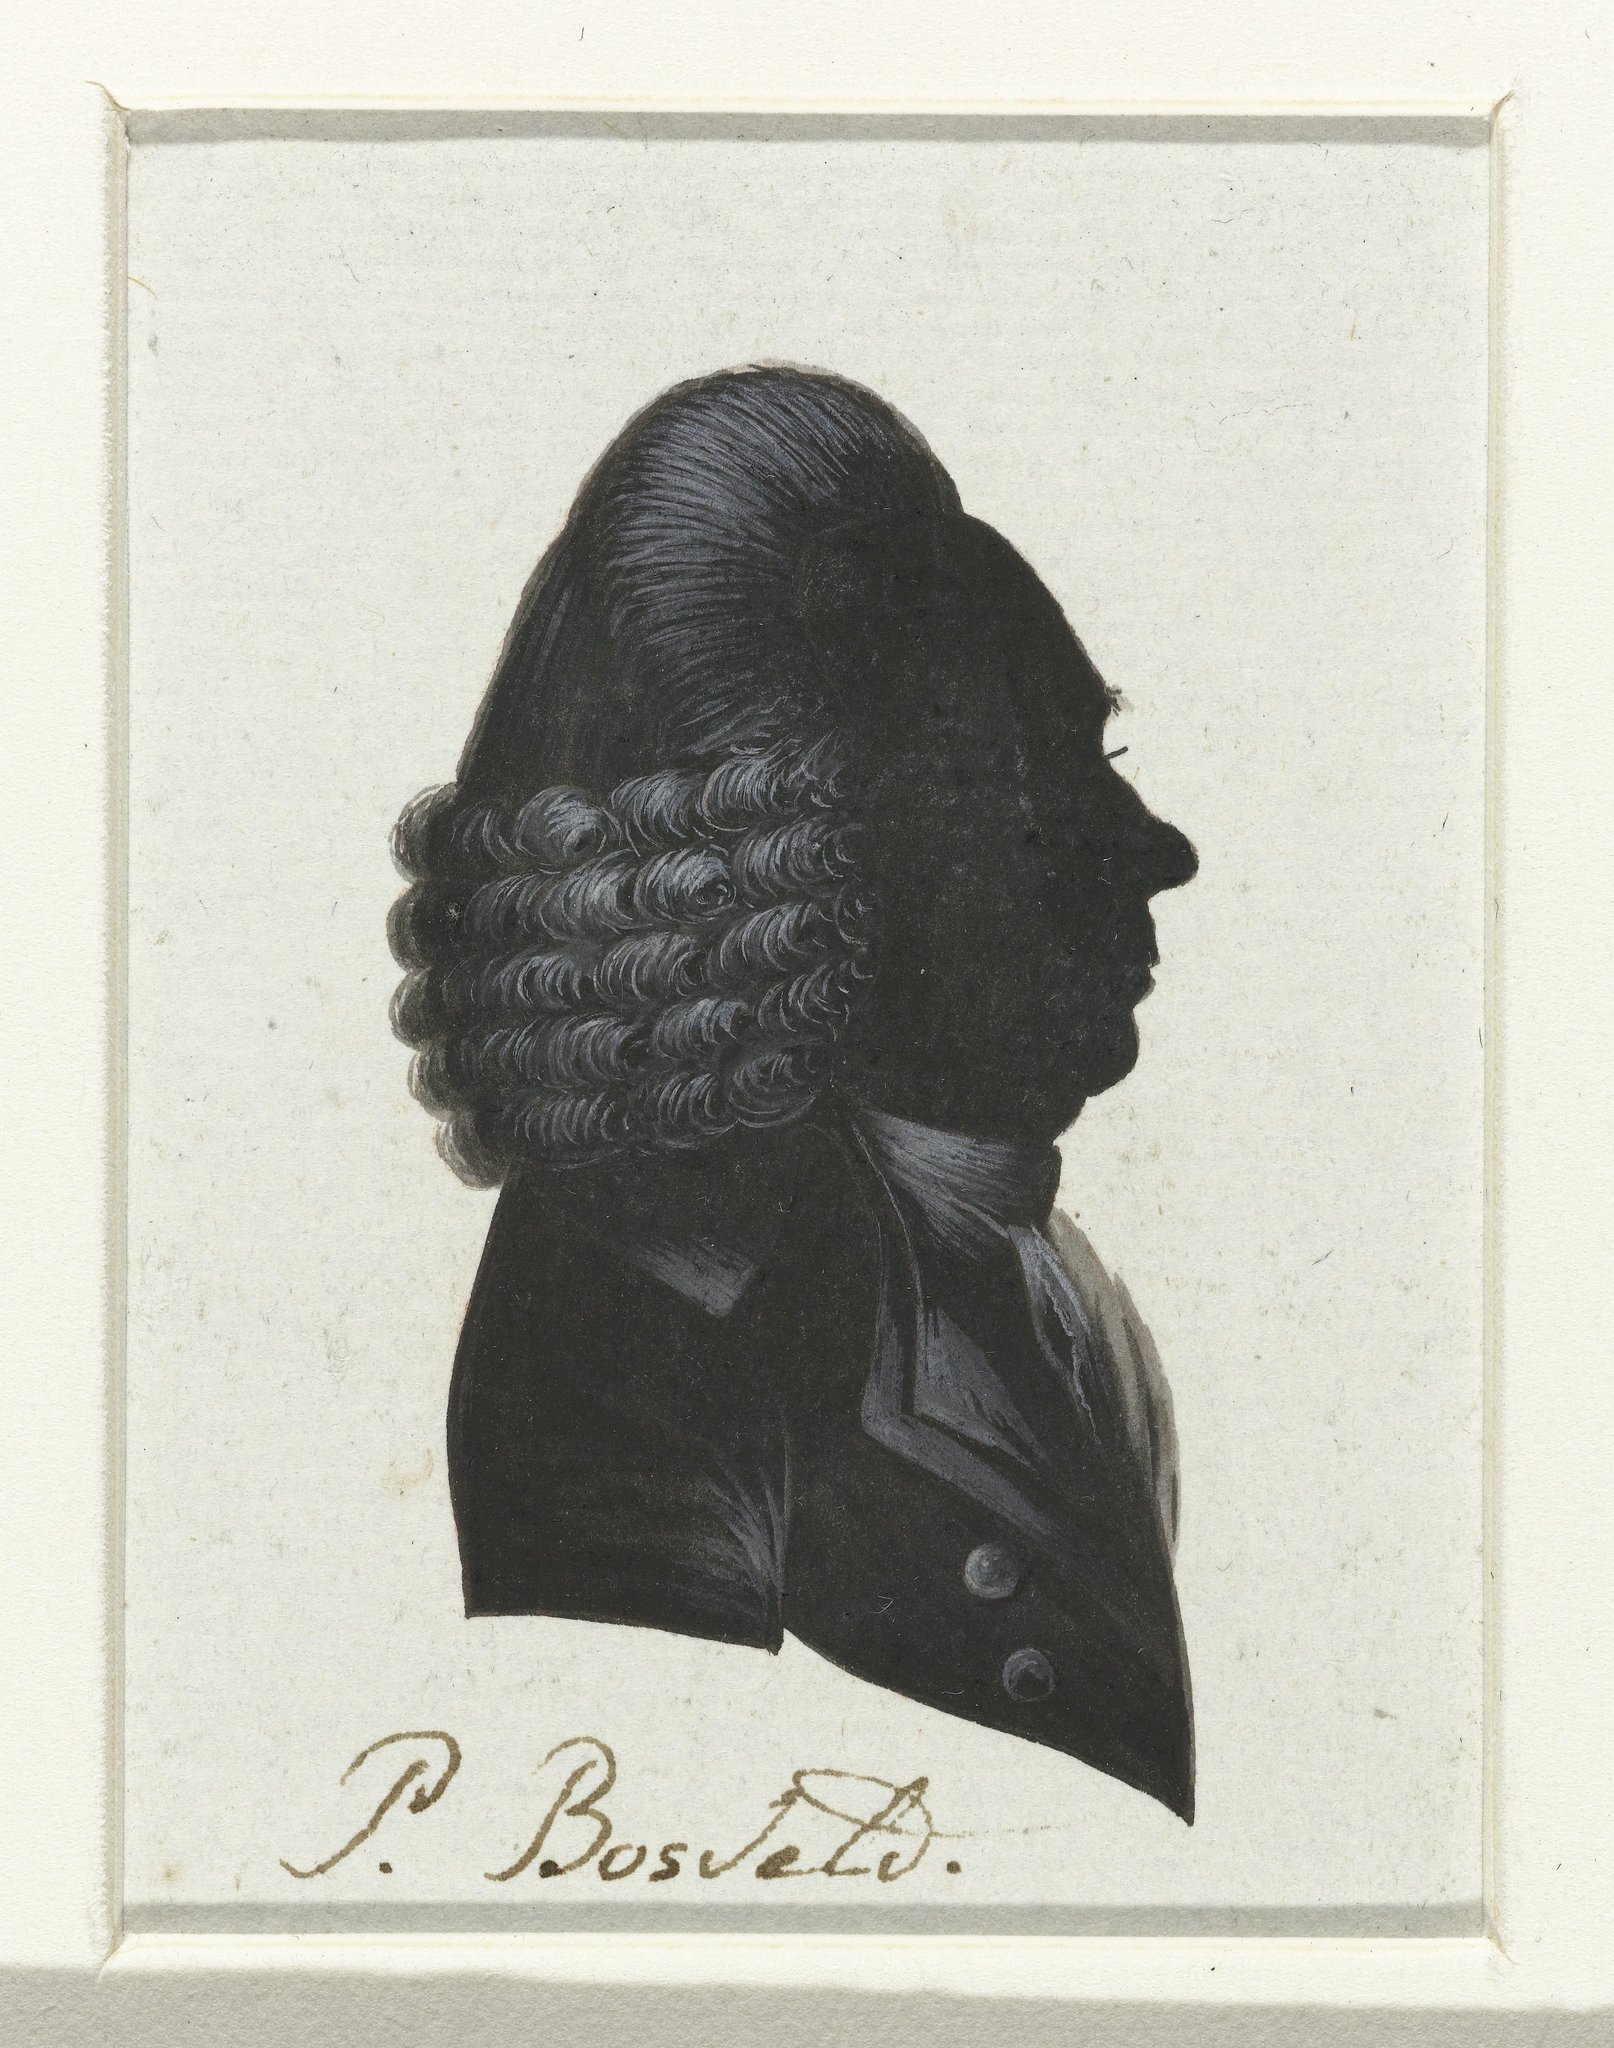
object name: silhouette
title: Representanten van de eerste Nationale Vergadering van de Bataafse Republiek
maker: hausdorff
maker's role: draughtsman, print maker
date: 1796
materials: ink, paper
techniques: drawing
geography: netherlands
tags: historical persons (+ profile portrait), the hague, dordrecht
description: Silhouettes of members of the National Assembly. India ink on paper, 1796. Early in 1795 Stadholder William V fled to England. In the Republic a new regime was installed. A year later, the country held its first general election. Every Dutch man over the age of twenty and not on poor relief was entitled to vote for a candidate to the National Assembly, the parliament of the Batavian Republic, as the country was known between 1795 and 1806. The 126 representatives who sat in the assembly were drawn from the educated, progressive elite of Dutch society.